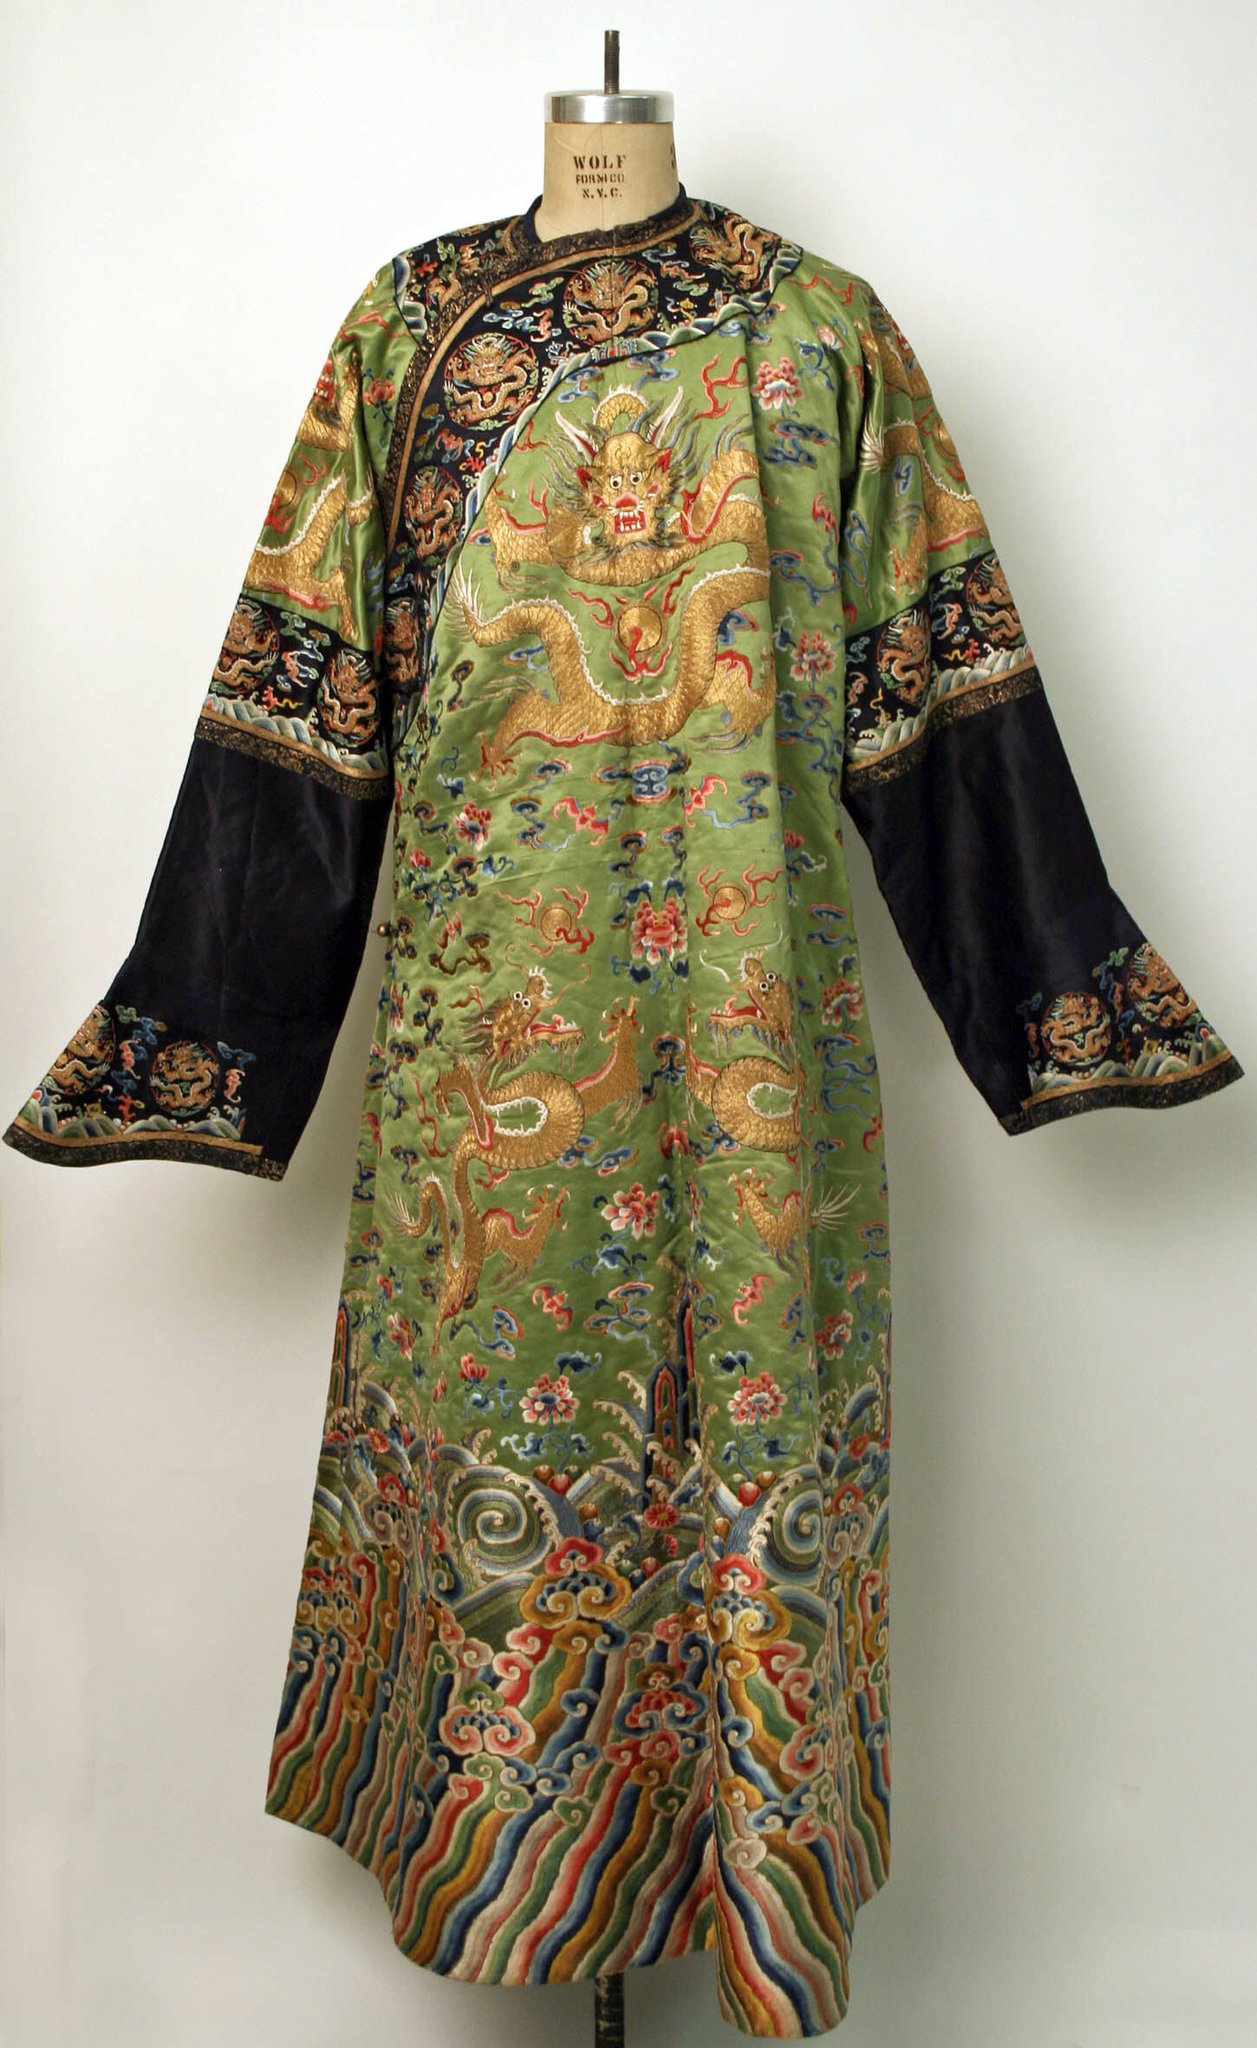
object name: robe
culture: chinese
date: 1801-1900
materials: metal thread, silk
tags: dragons